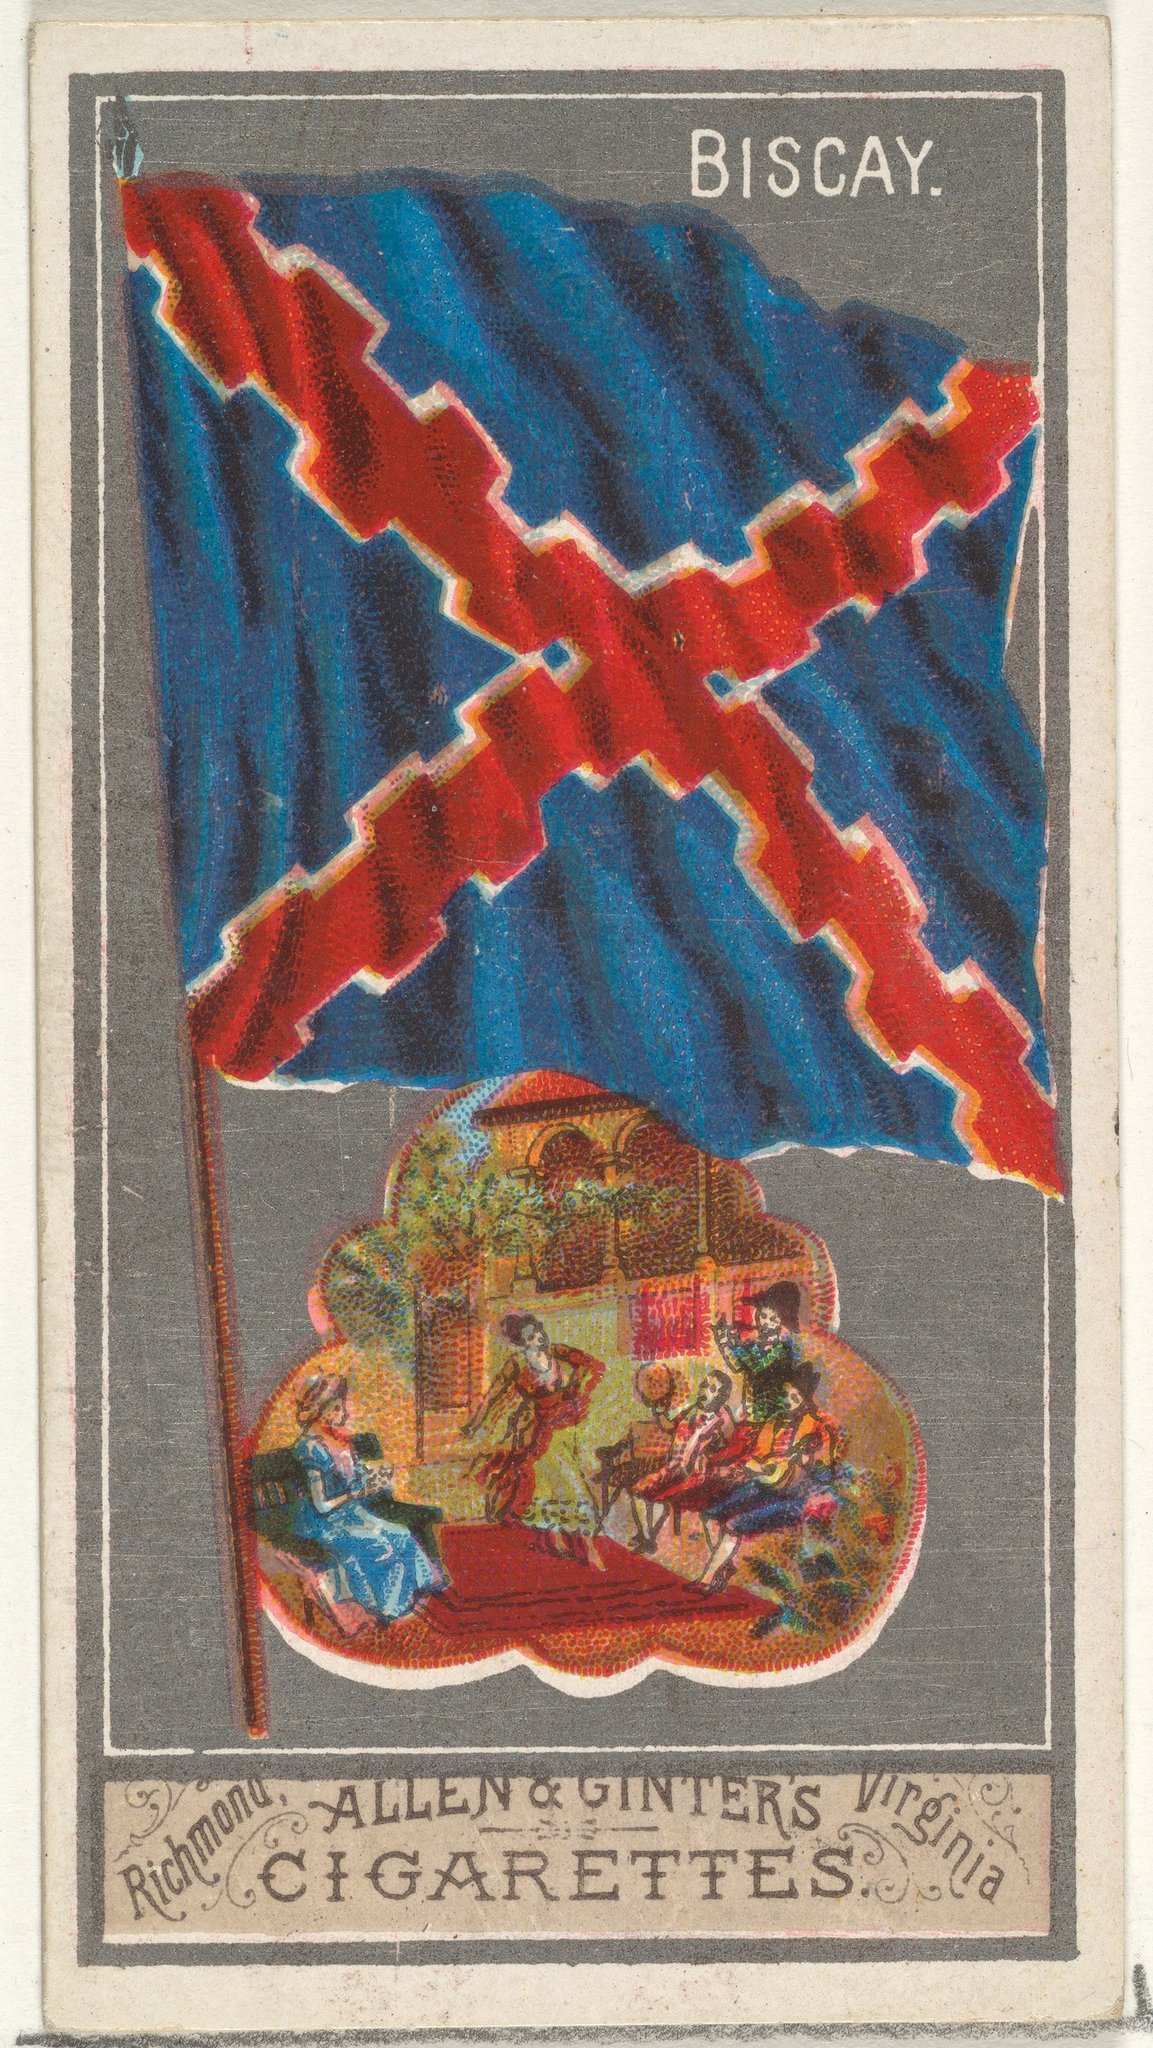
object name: print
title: Biscay, from the City Flags series (N6) for Allen & Ginter Cigarettes Brands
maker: allen & ginter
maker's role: publisher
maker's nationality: american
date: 1887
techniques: color lithograph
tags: flags